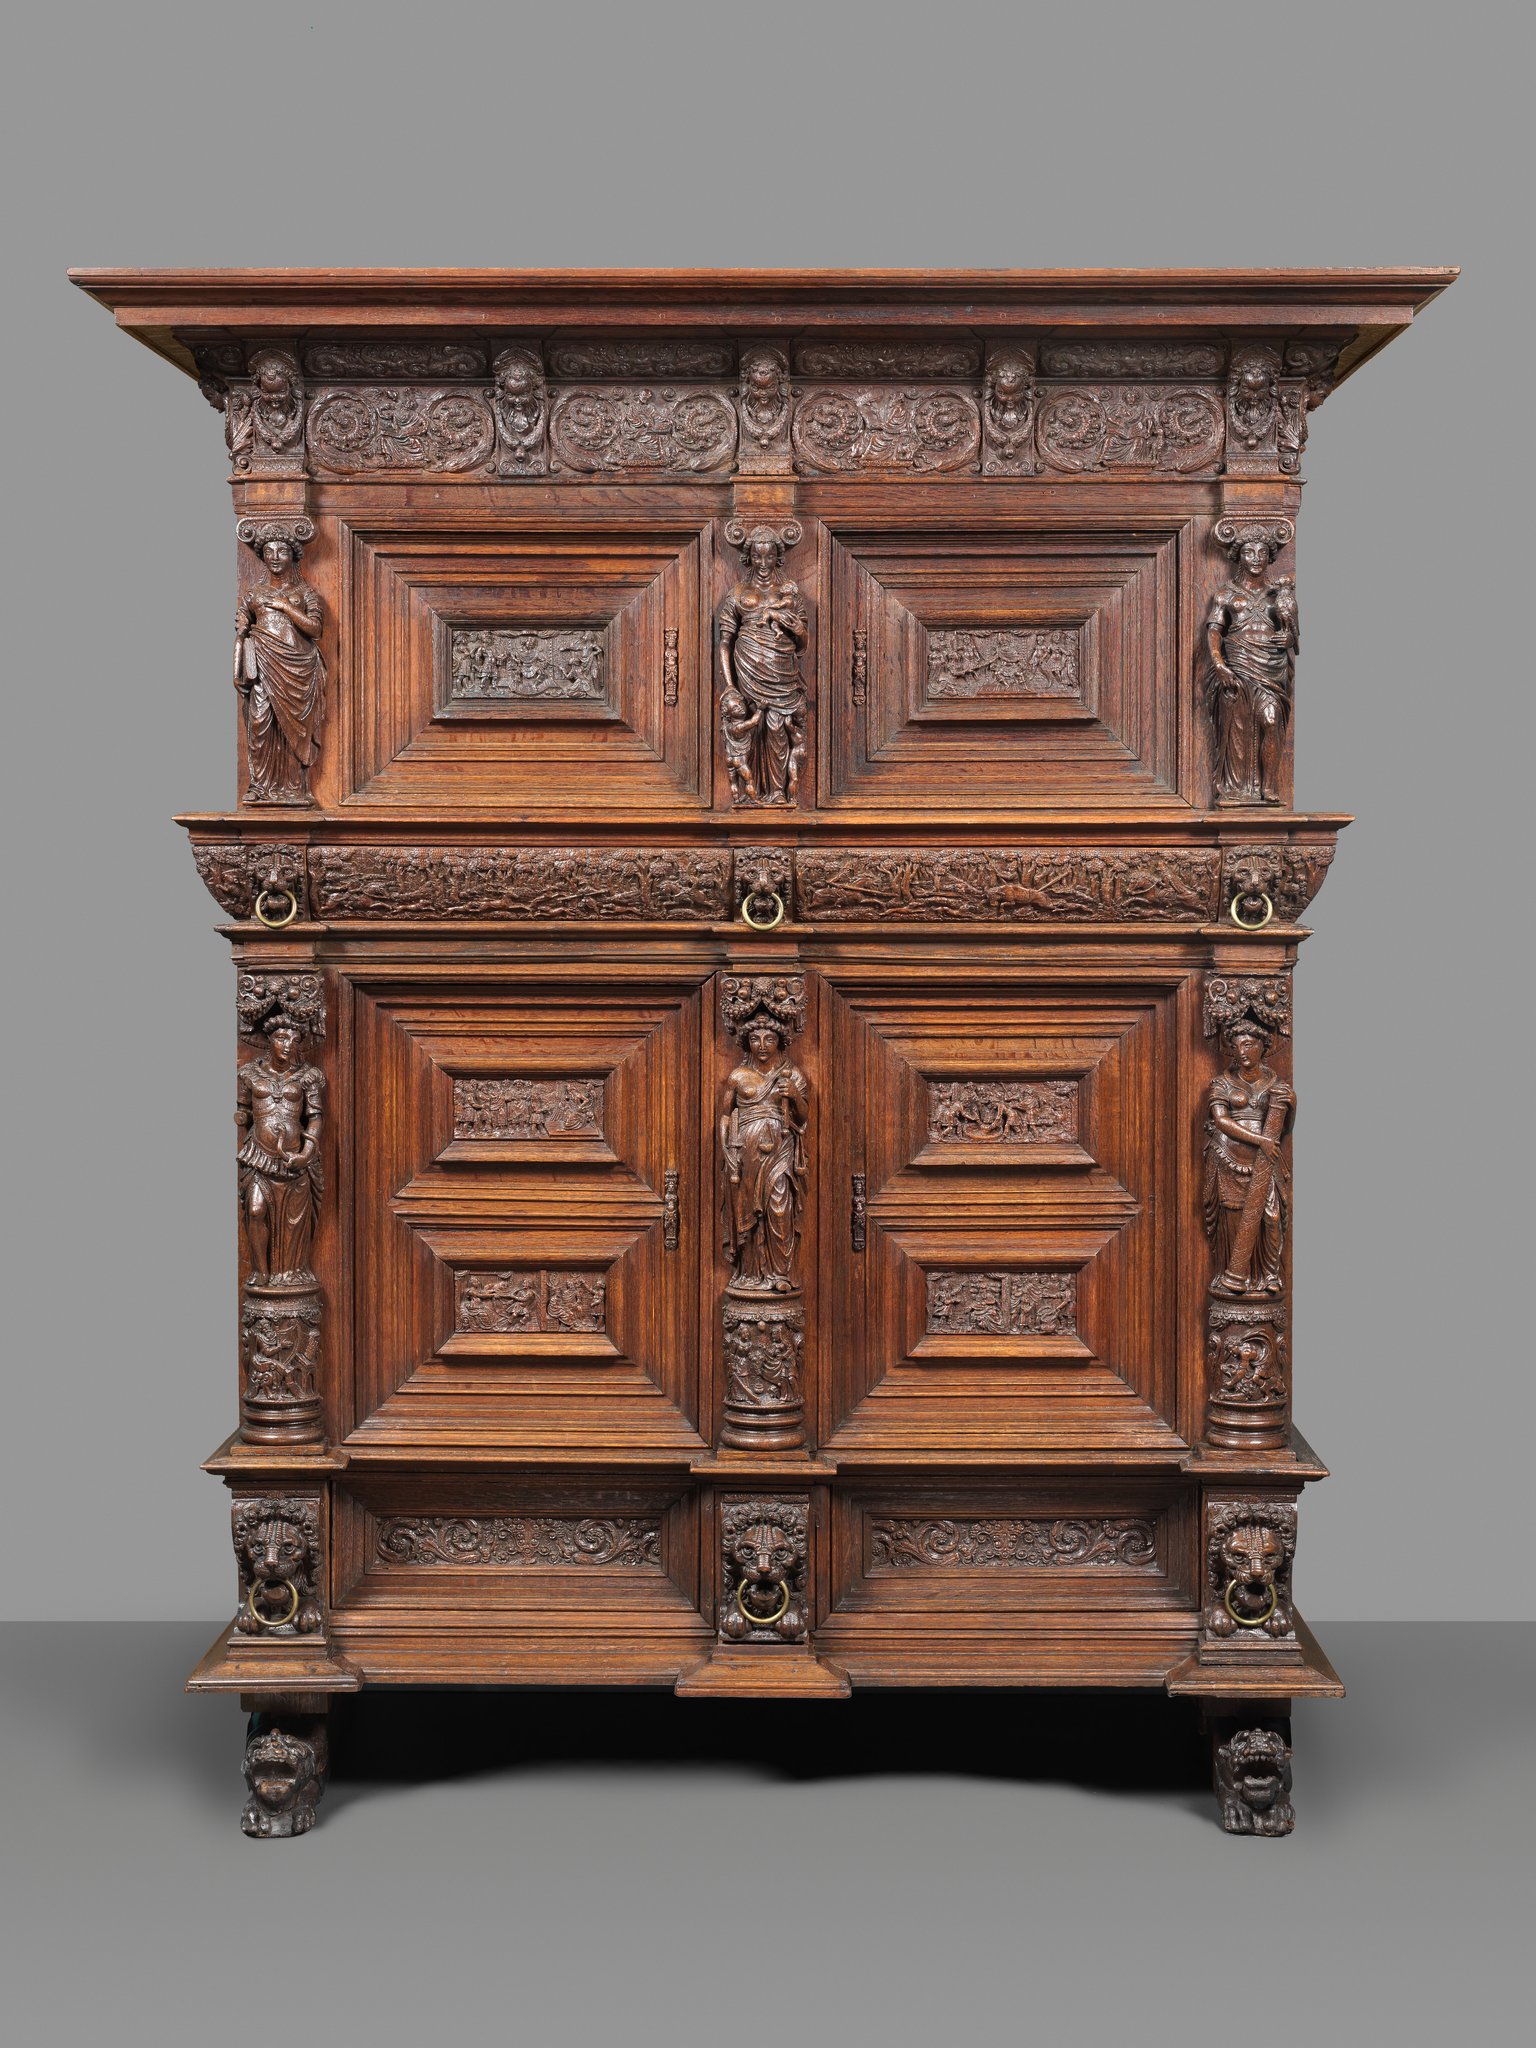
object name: cupboard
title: Cupboard (Beeldenkast)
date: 1622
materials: wood